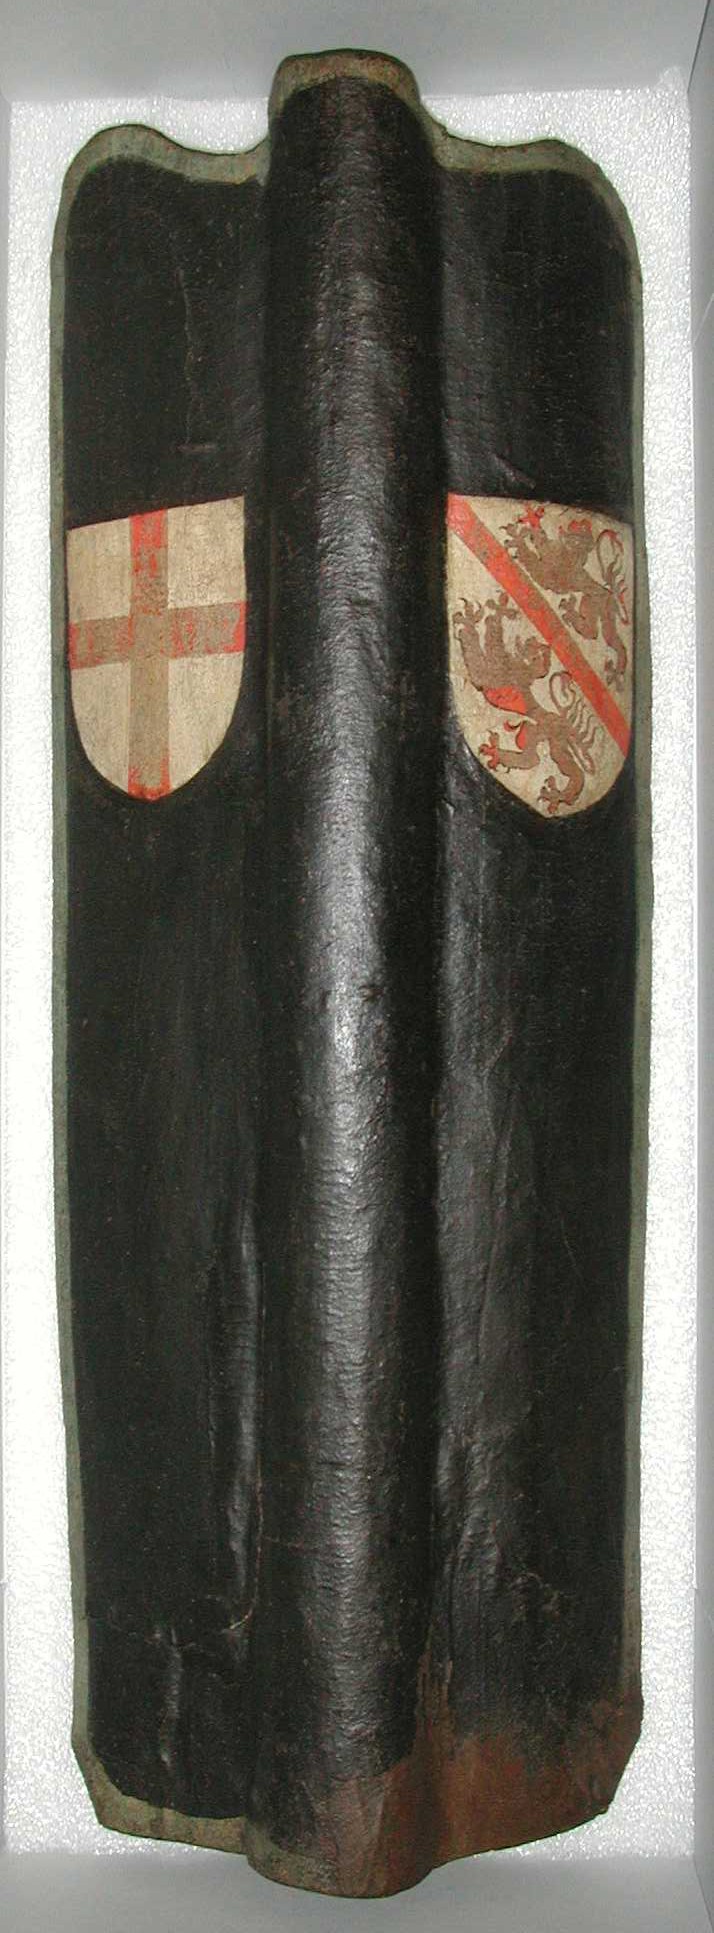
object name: shield pavise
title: Archer's Shield (Pavise)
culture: swiss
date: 1401-1500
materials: gesso, pigment, wood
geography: switzerland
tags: coat of arms